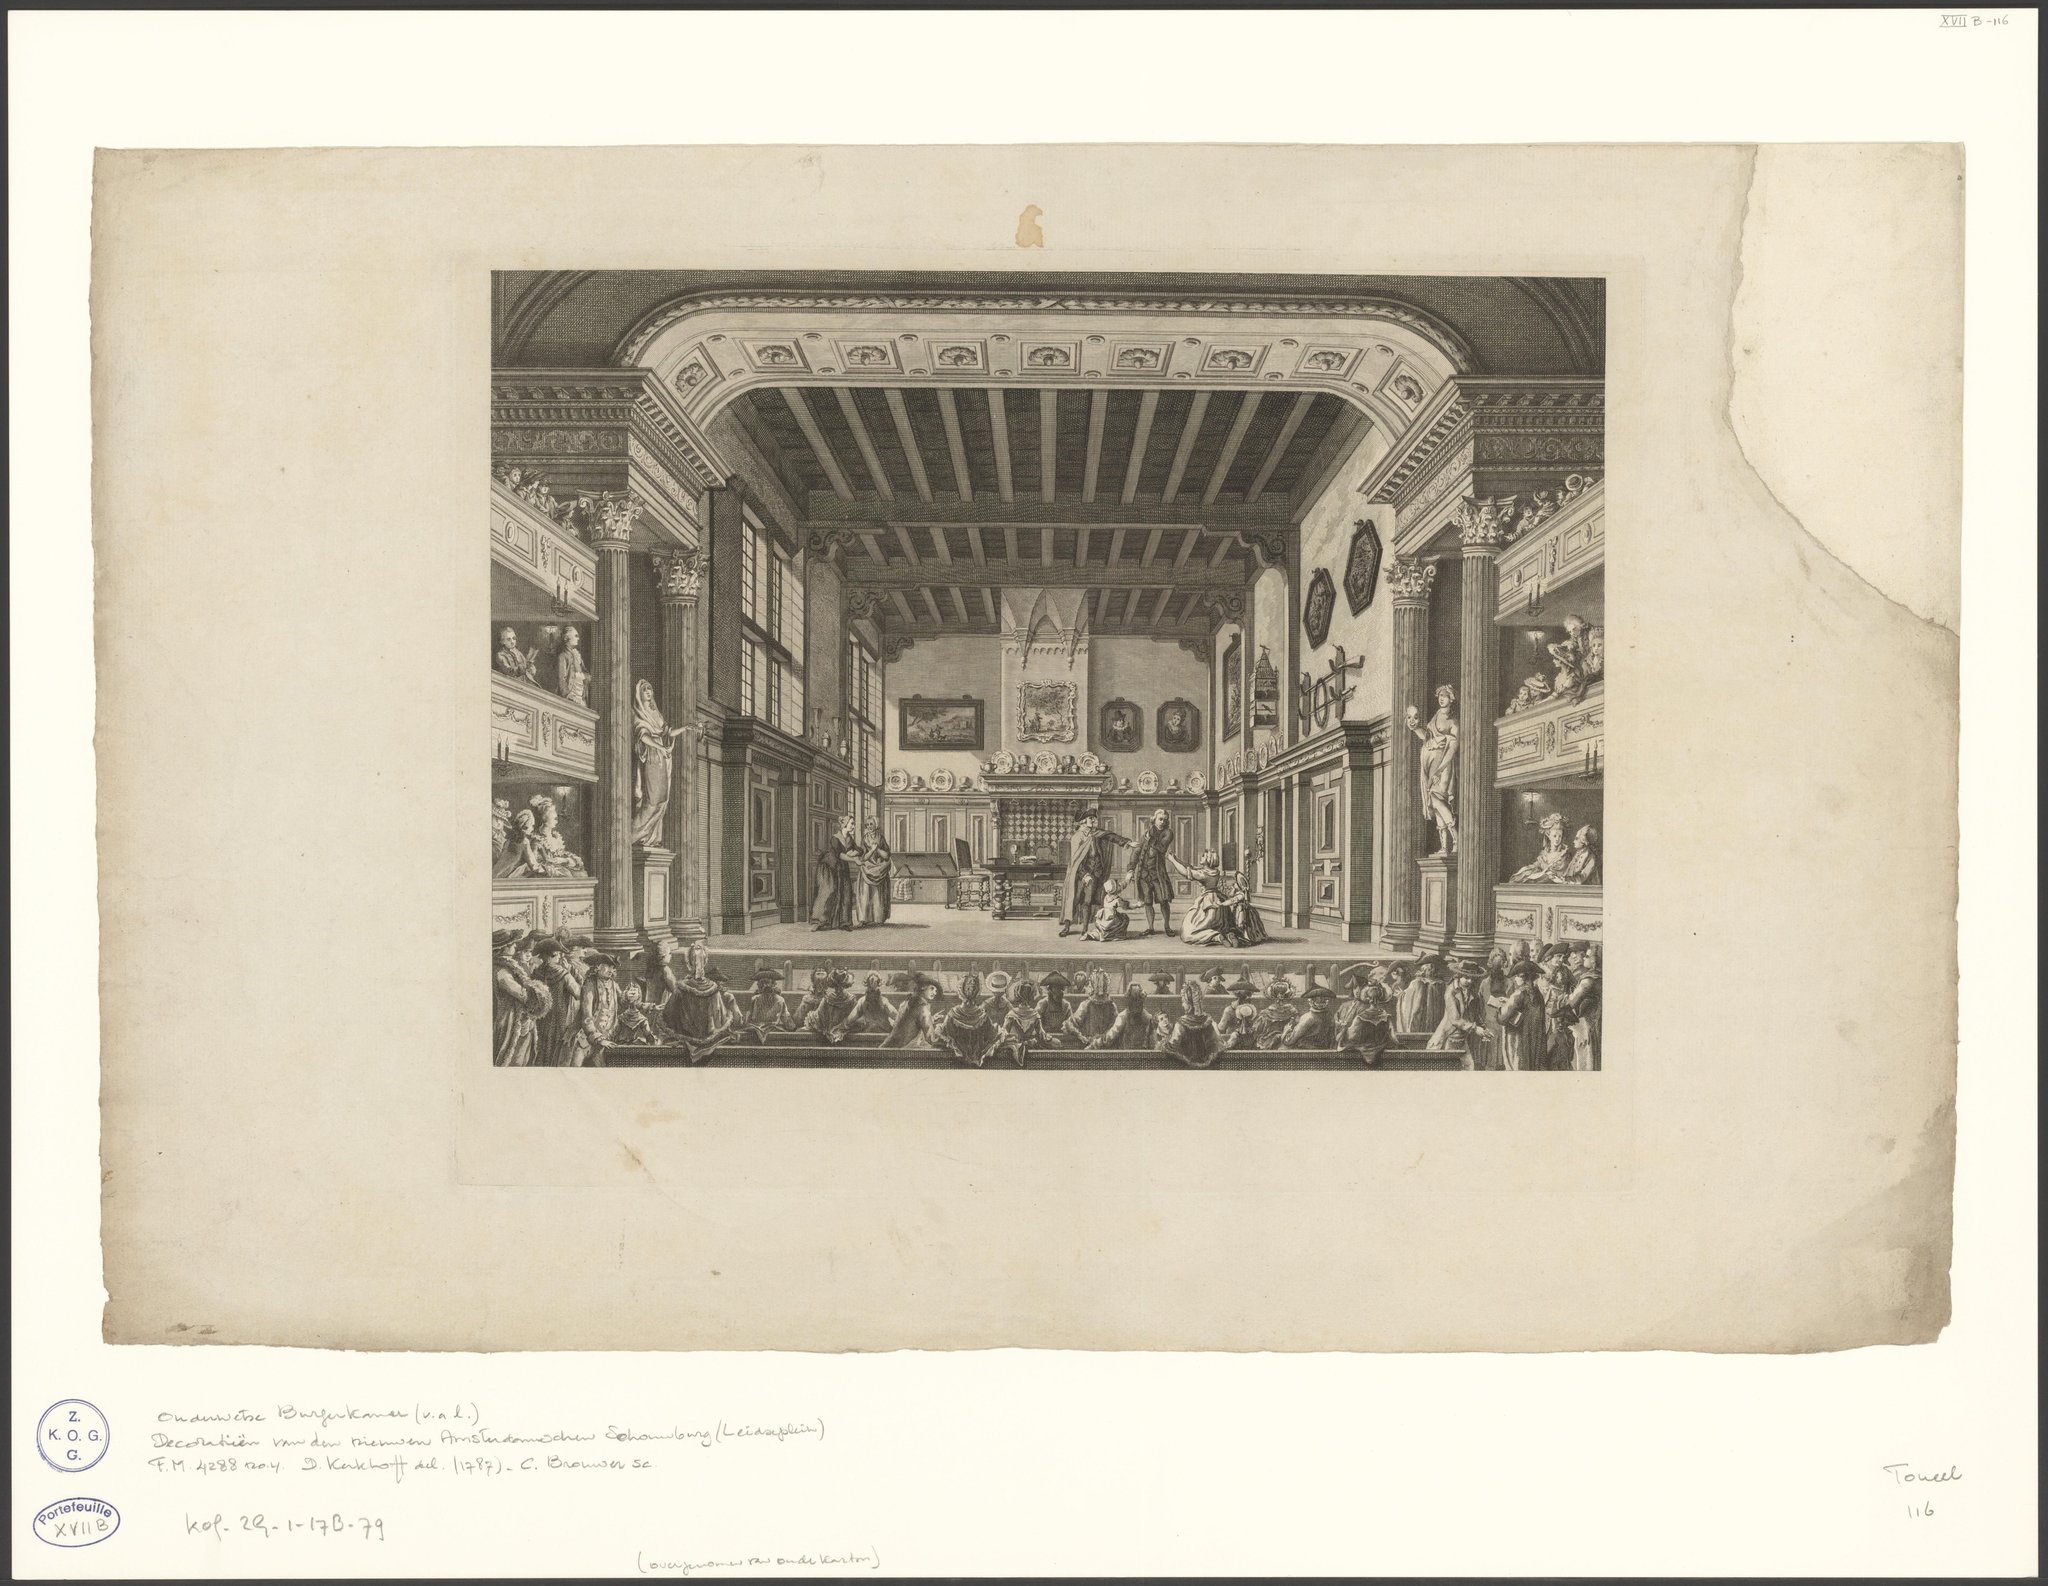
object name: print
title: Toneeldecors van de nieuwe Amsterdamse Schouwburg, 1787-1794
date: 1787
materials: paper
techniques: engraving, etching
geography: amsterdam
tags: theatre, theatrical performance, stage design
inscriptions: collector's mark: Lugt 1641, stamp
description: Toneelvoorstelling in de nieuwe Amsterdamse Schouwburg met het coulissendecor De Ouderwetsche Burgerkamer, met scène uit De Stiefmoêr. Het decor gedrukt van een aparte plaat binnen een passe-partout met de zaal, zijloges, pilaren met standbeelden en de façade van het toneel. In het onderschrift een zesregelig vers. Onderdeel van de serie van veertien toneeldecors van de nieuwe Amsterdamse Schouwburg, 1787-1794. Onderwerpsrubrieken binnen de Atlas Zeden en Gewoonten: Schoone kunsten, Tooneel, Decors voor de Schouwburg.